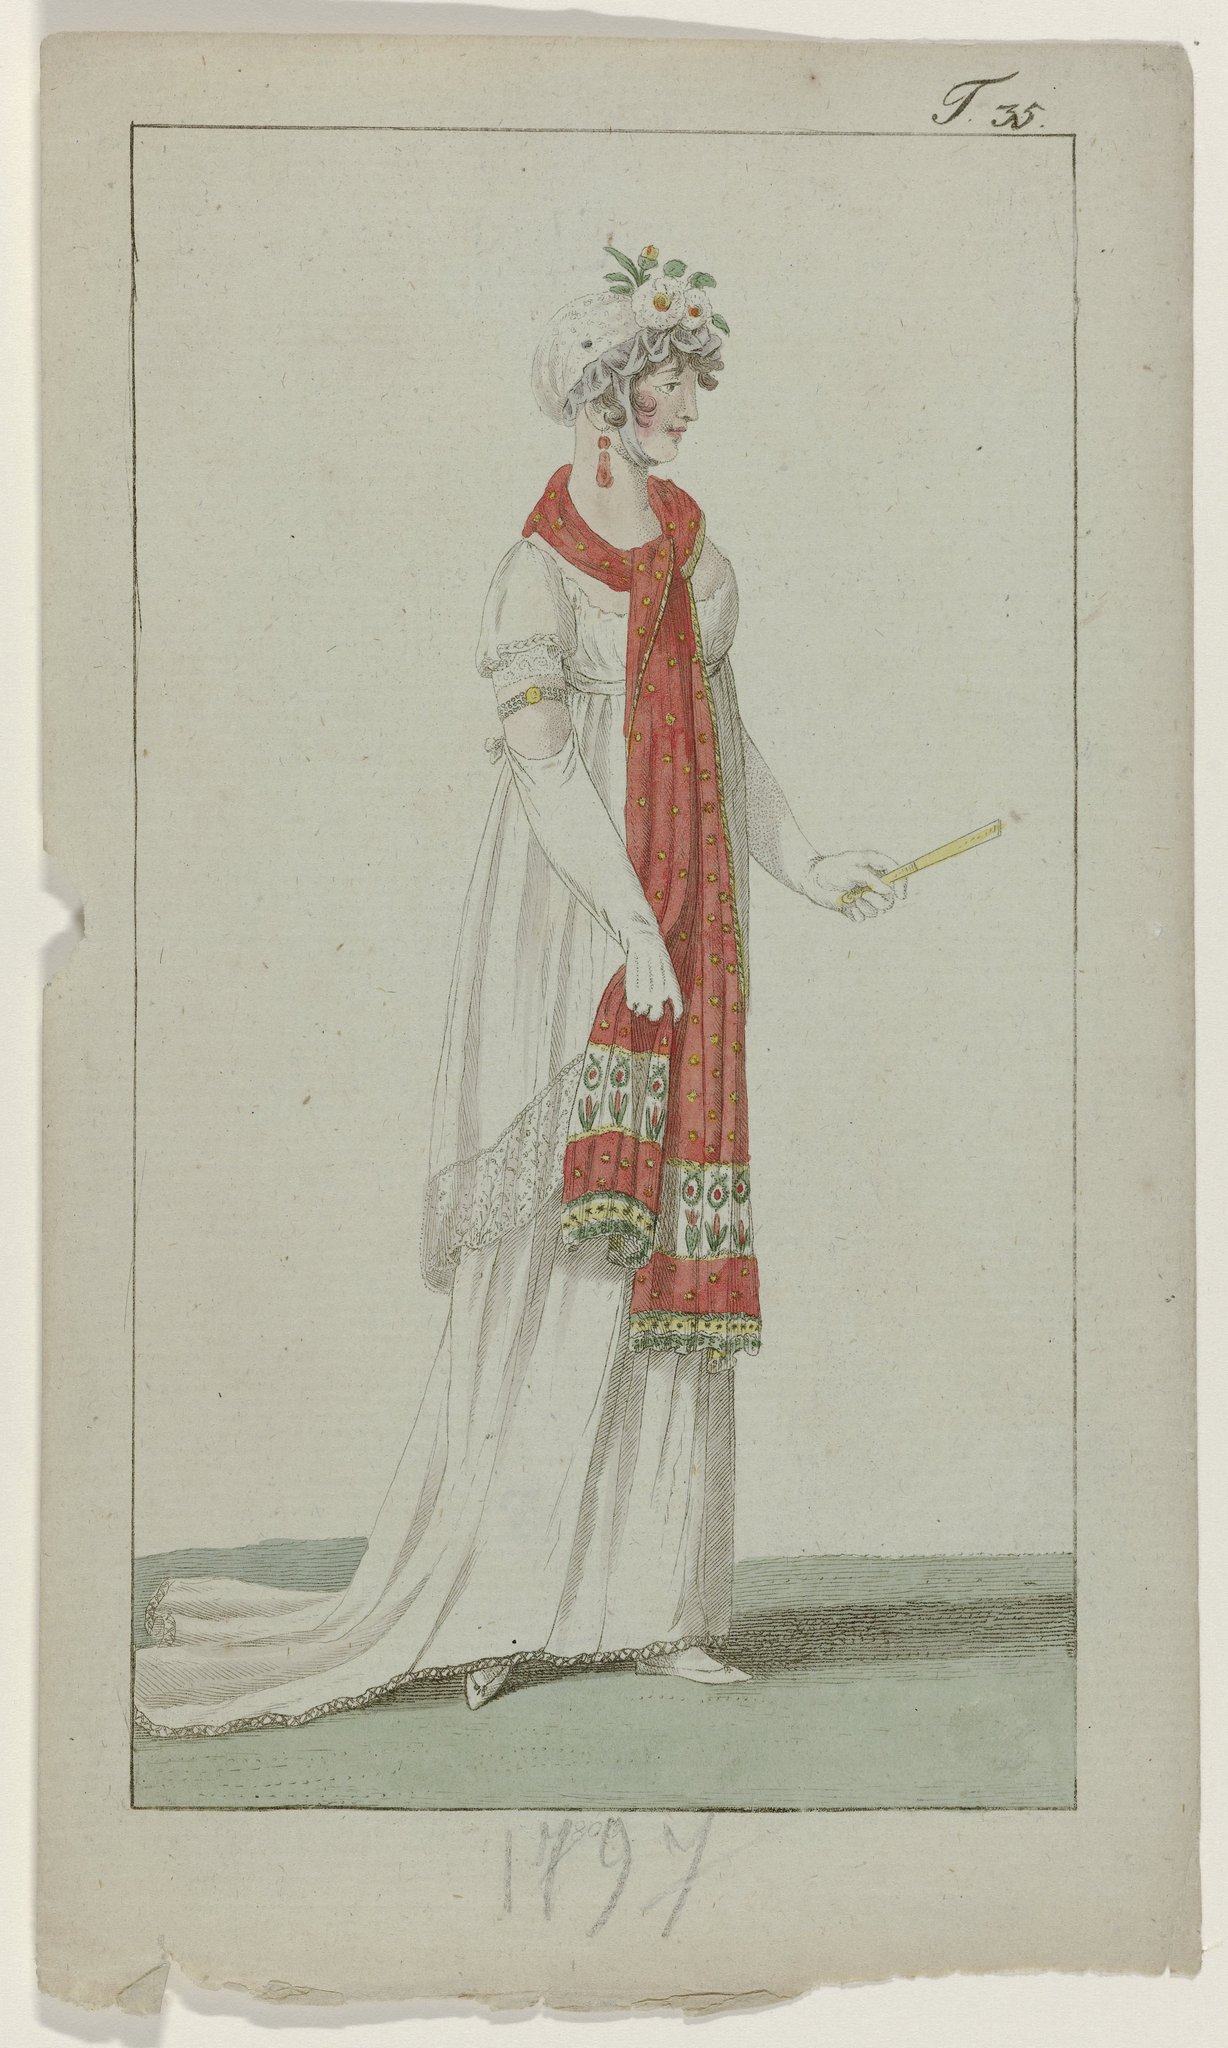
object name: fashion print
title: Journal des Luxus und der Moden, 1797, T 35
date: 1797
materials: paper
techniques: etching, hand coloring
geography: weimar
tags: ear-rings (+ women's clothes), gloves, mittens (long gloves) (+ women's clothes), clothing for the upper part of the body (shawl) (+ women's clothes), head-gear: cap (+ women's clothes), fashion plates, shoes, sandals (+ women's clothes), dress, gown (+ women's clothes), fan (+ women's clothes), bracelet, wristlet (+ women's clothes)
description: Staande vrouw gekleed in een tuniek met korte mouwen op een rok met sleep. Om de hals een gestippelde sjaal waarvan de uiteinden zijn versierd met een bloemmotief. Verdere accessoires: muts met bloemen, oorbel in het rechteroor, armband om de rechter bovenarm, lange handschoenen, waaier, platte schoenen. Prent uit het modetijdschrift Journal des Luxus und der Moden, uitgegeven door Friedrich Justin Bertuch en Georg Melchior Kraus, Weimar, 1786-1826.